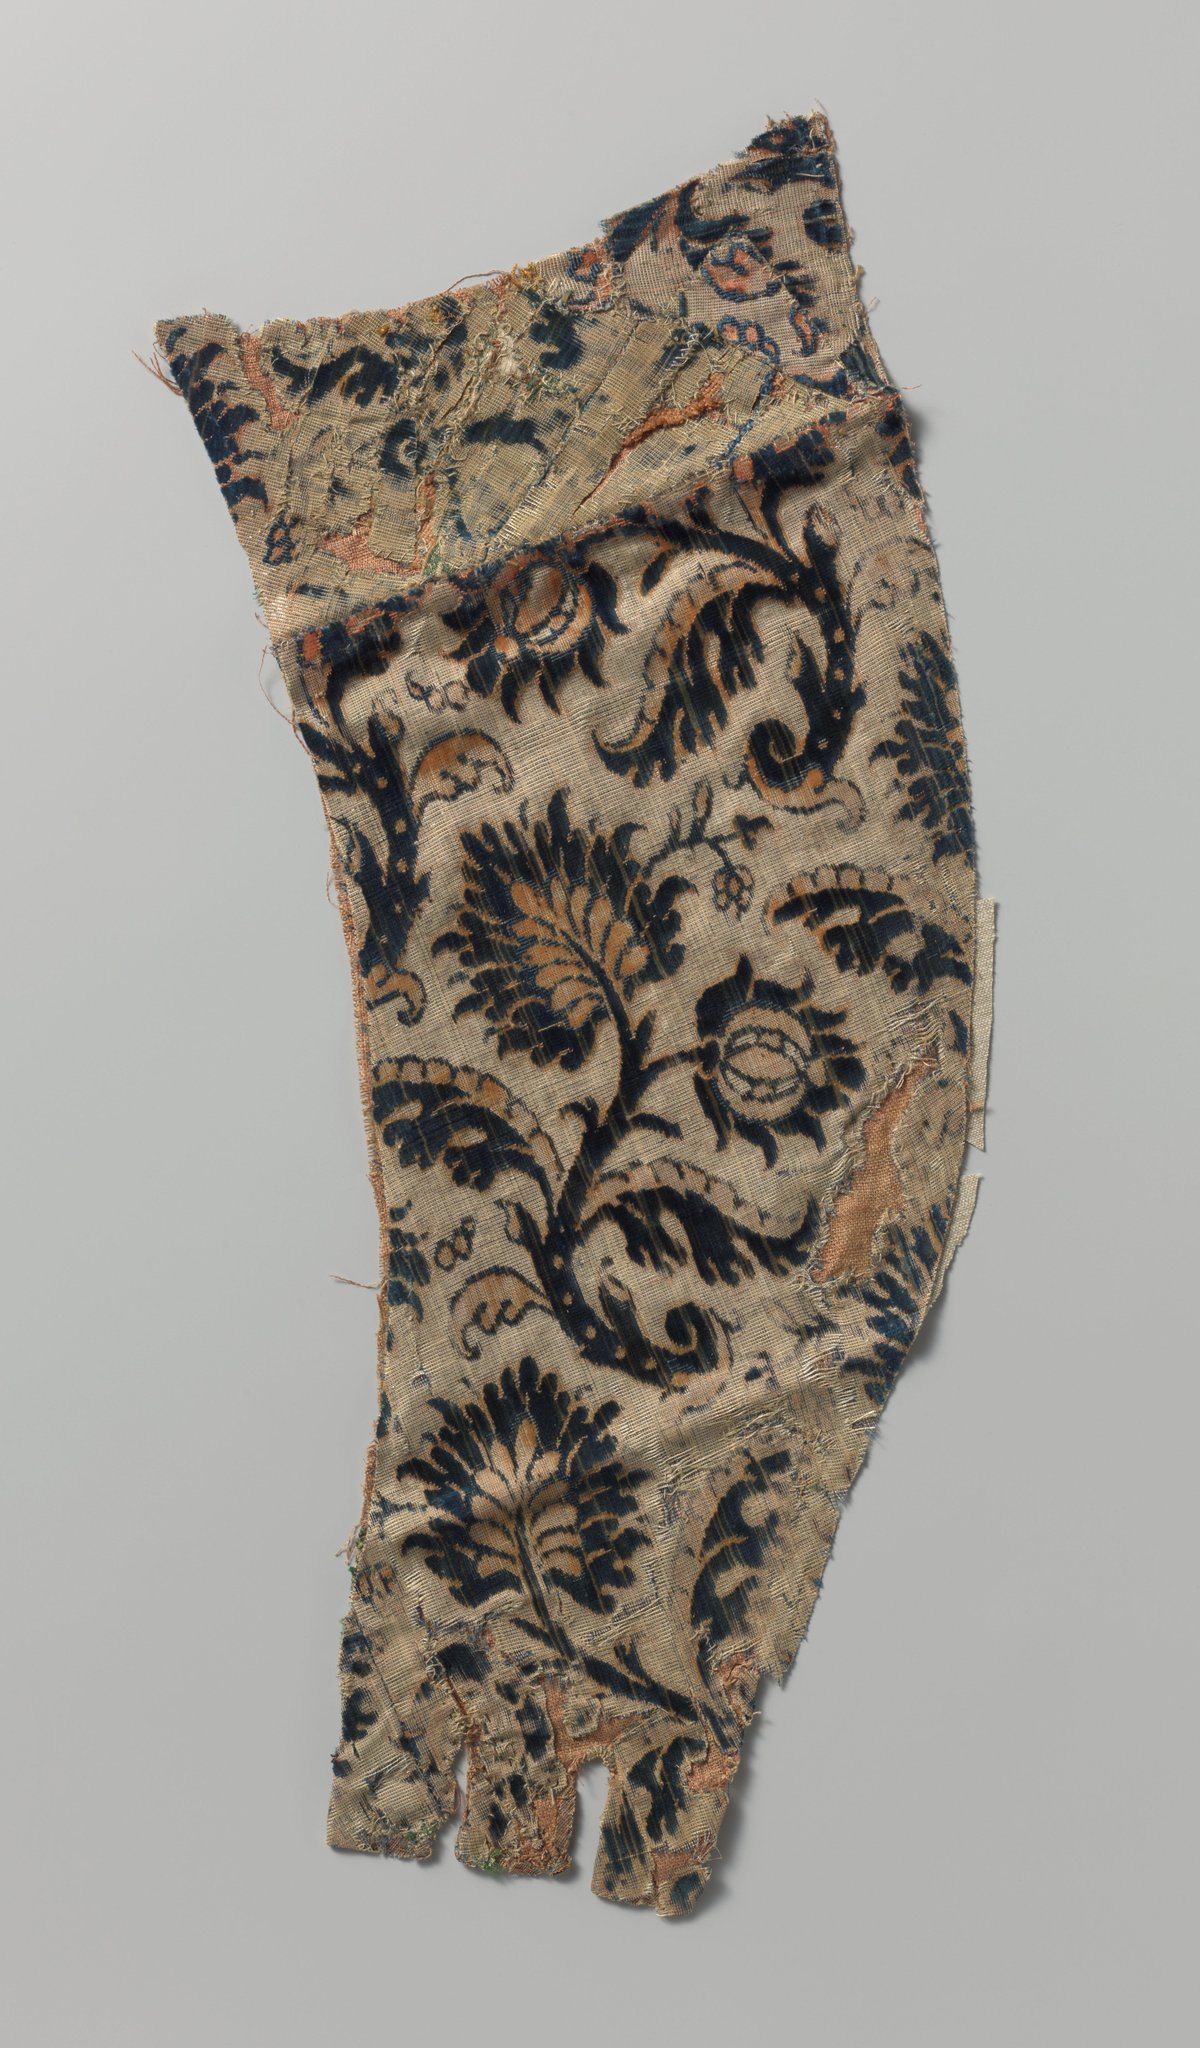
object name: brokaatfluweel, fluweelbrokaat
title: Fragment zijden fluweelbrokaat met op lichte grond een patroon van gekrulde takken met bladeren en bloemen in blauw en roze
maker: Anonymous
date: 1600-1699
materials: linen, silk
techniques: velvet, weave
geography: italy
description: Fragment zijden fluweelbrokaat met op lichte grond een patroon van gekrulde takken met bladeren en bloemen (granaatappels?) in indigoblauw en zalmroze. Italië,16de eeuw?